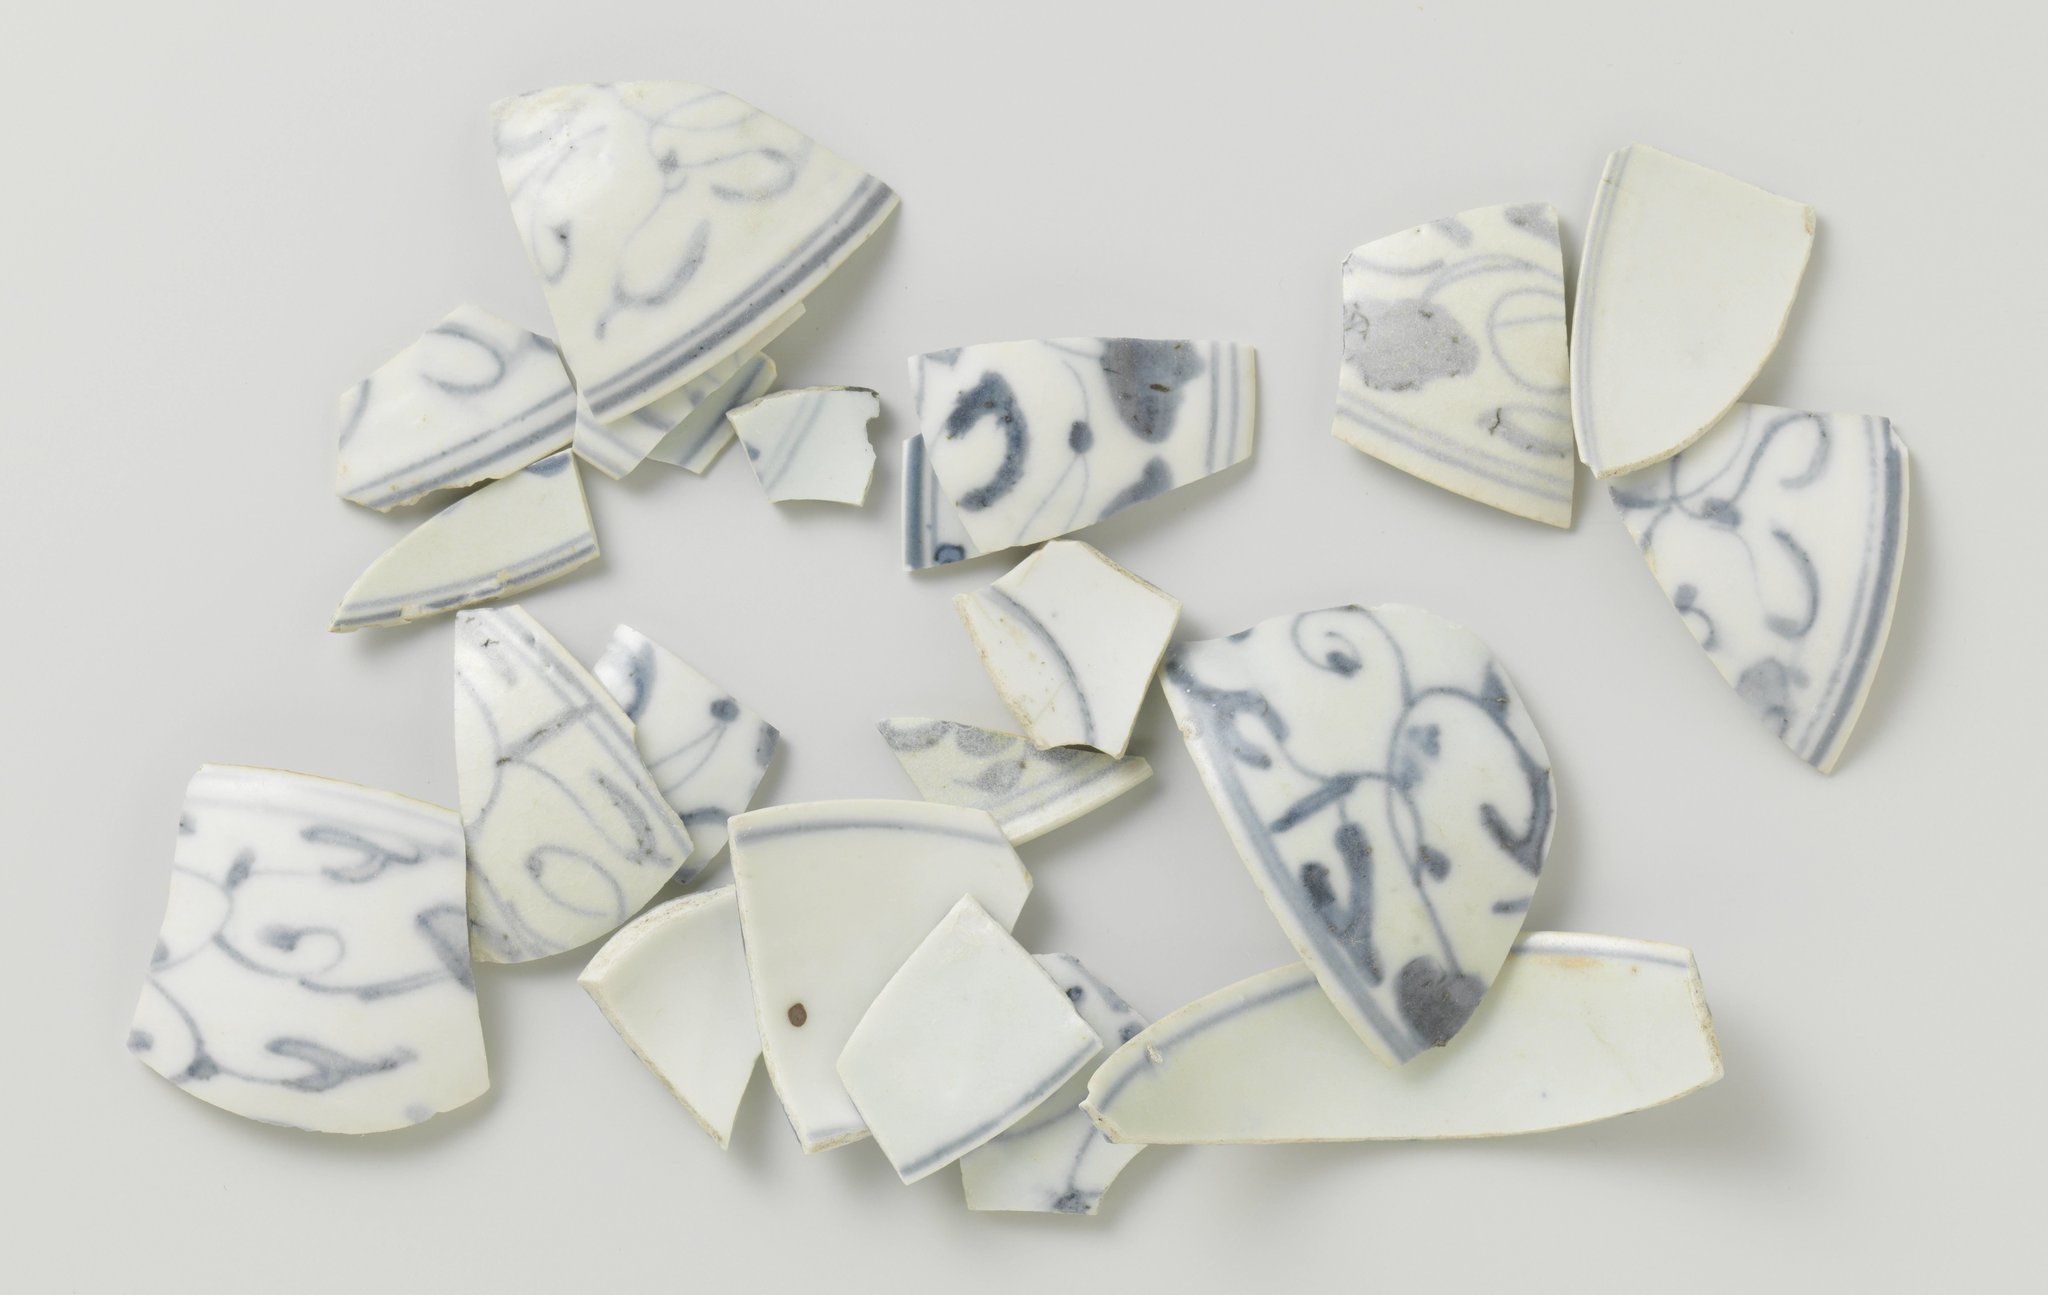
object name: sherd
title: Scherven van porselein uit V.O.C.-schip de 'Witte Leeuw'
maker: Anonymous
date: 1613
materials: porcelain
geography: jingdezhen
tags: verenigde oostindische compagnie, sint-helena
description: Scherven van porselein uit V.O.C.-schip de 'Witte Leeuw'.